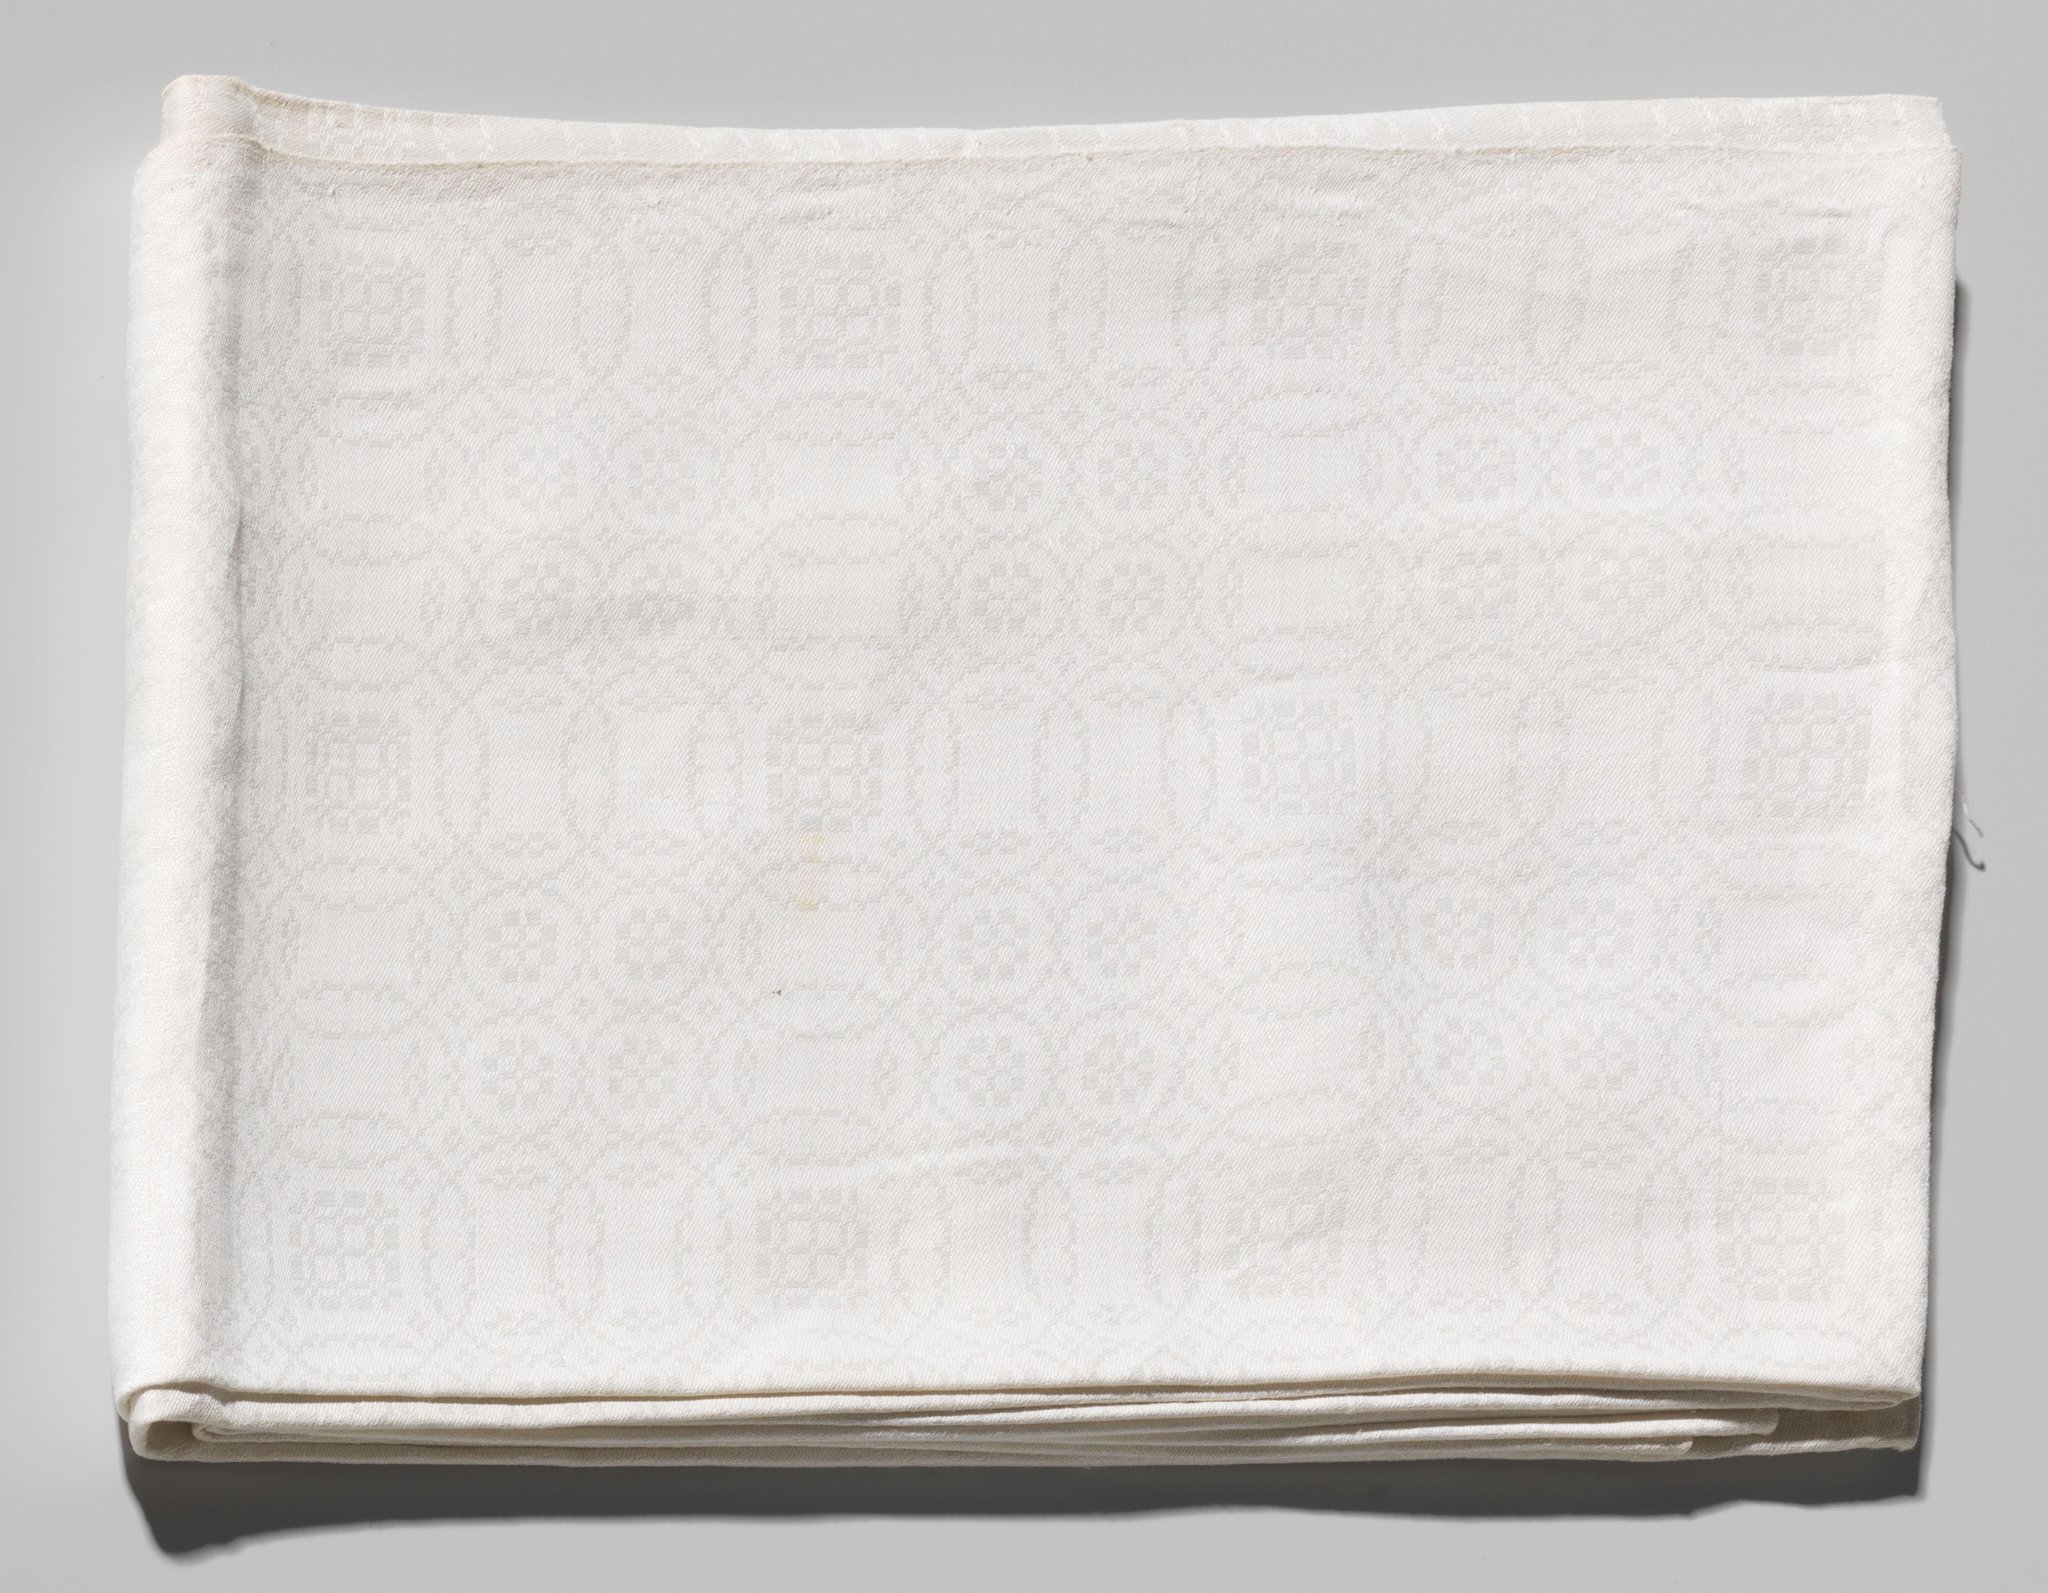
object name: napkin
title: Servet met pellenpatroon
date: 1700-1800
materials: linen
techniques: damask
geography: northern netherlands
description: Servet van wit linnendamast met fijn pellenpatroon. Oneindig rapport van recht boven en naast elkaar gerangschikte, elkaar doorsnijdende cirkels, gevuld met achthoeken en kruis van blokjes. Gemerkt in open matsteek T.R.